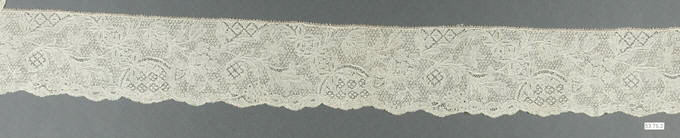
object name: border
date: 1701-1733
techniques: lace